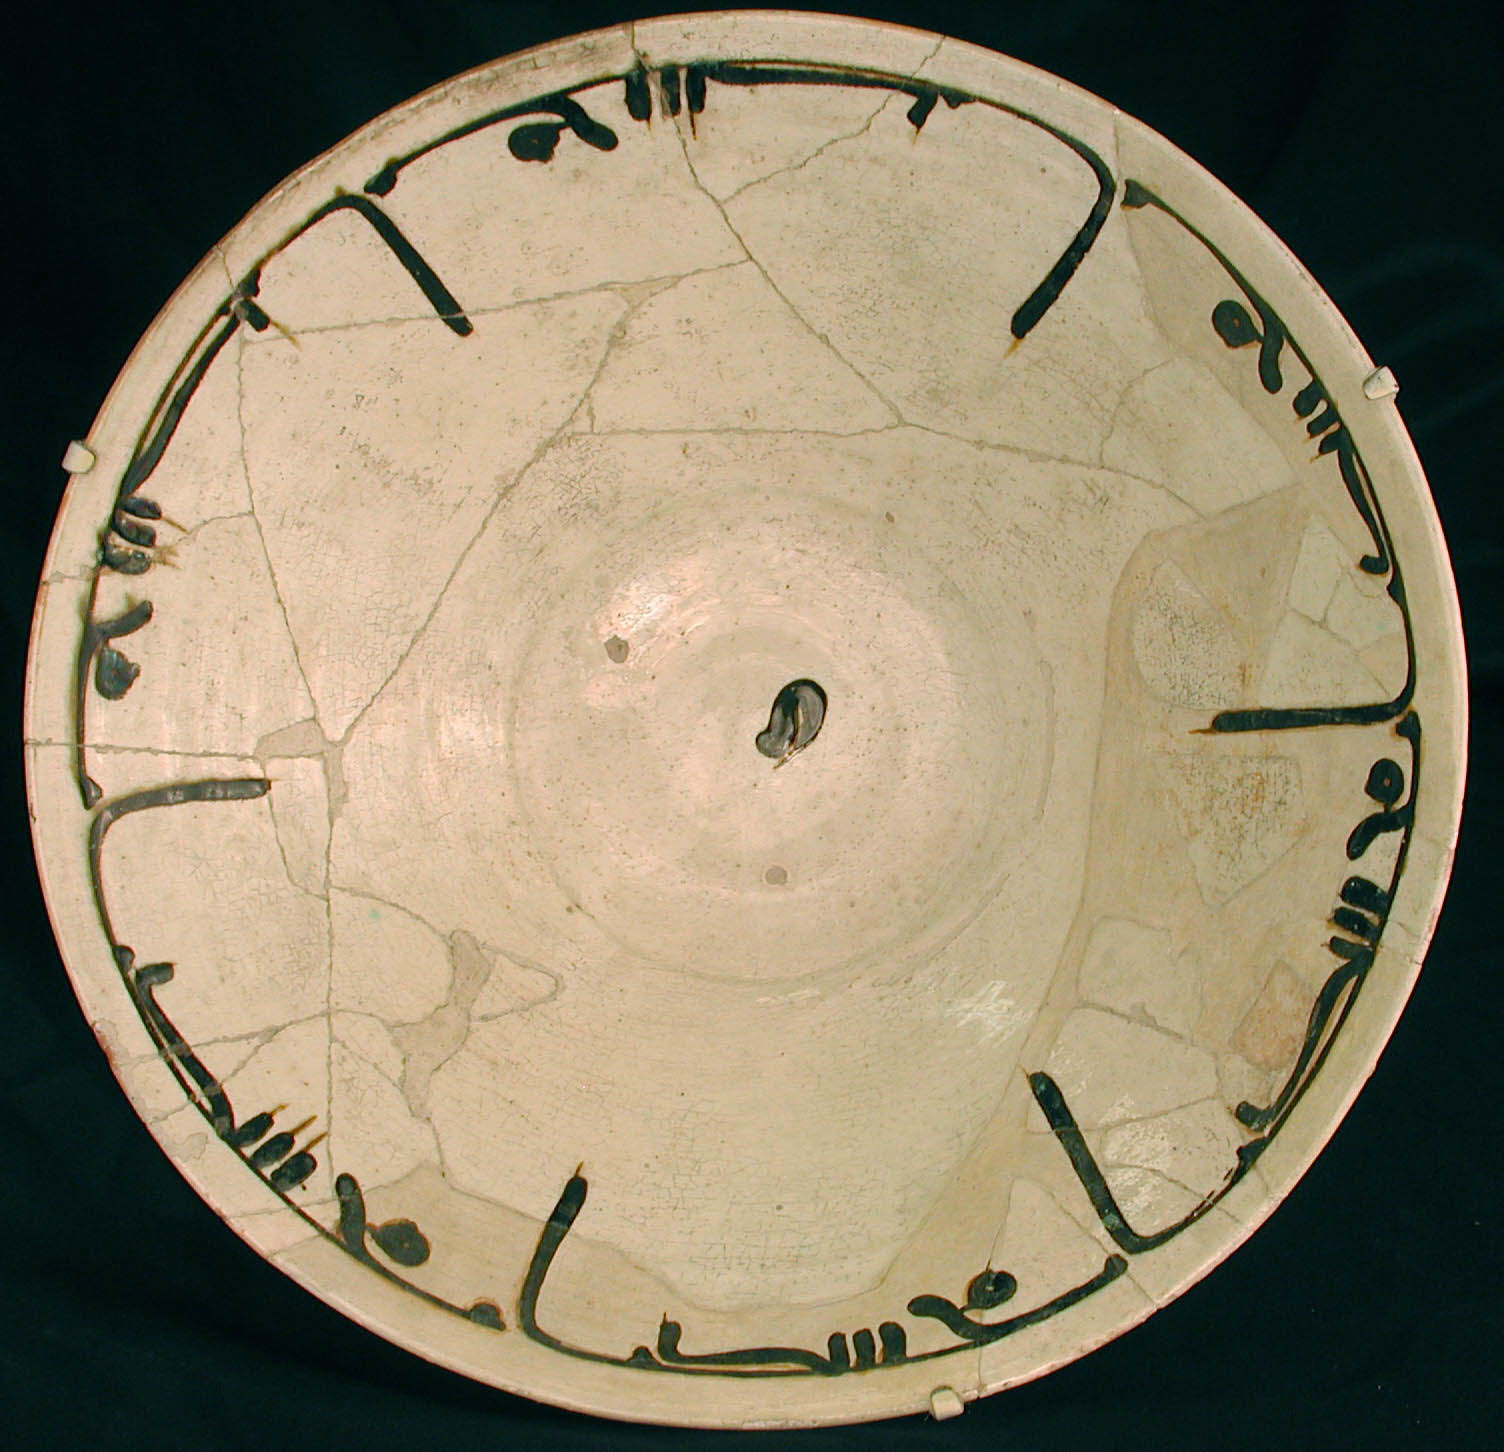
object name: bowl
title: Bowl with Repeating Inscription, "Oh, Abundant!"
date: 867-900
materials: earthenware, glaze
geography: iran